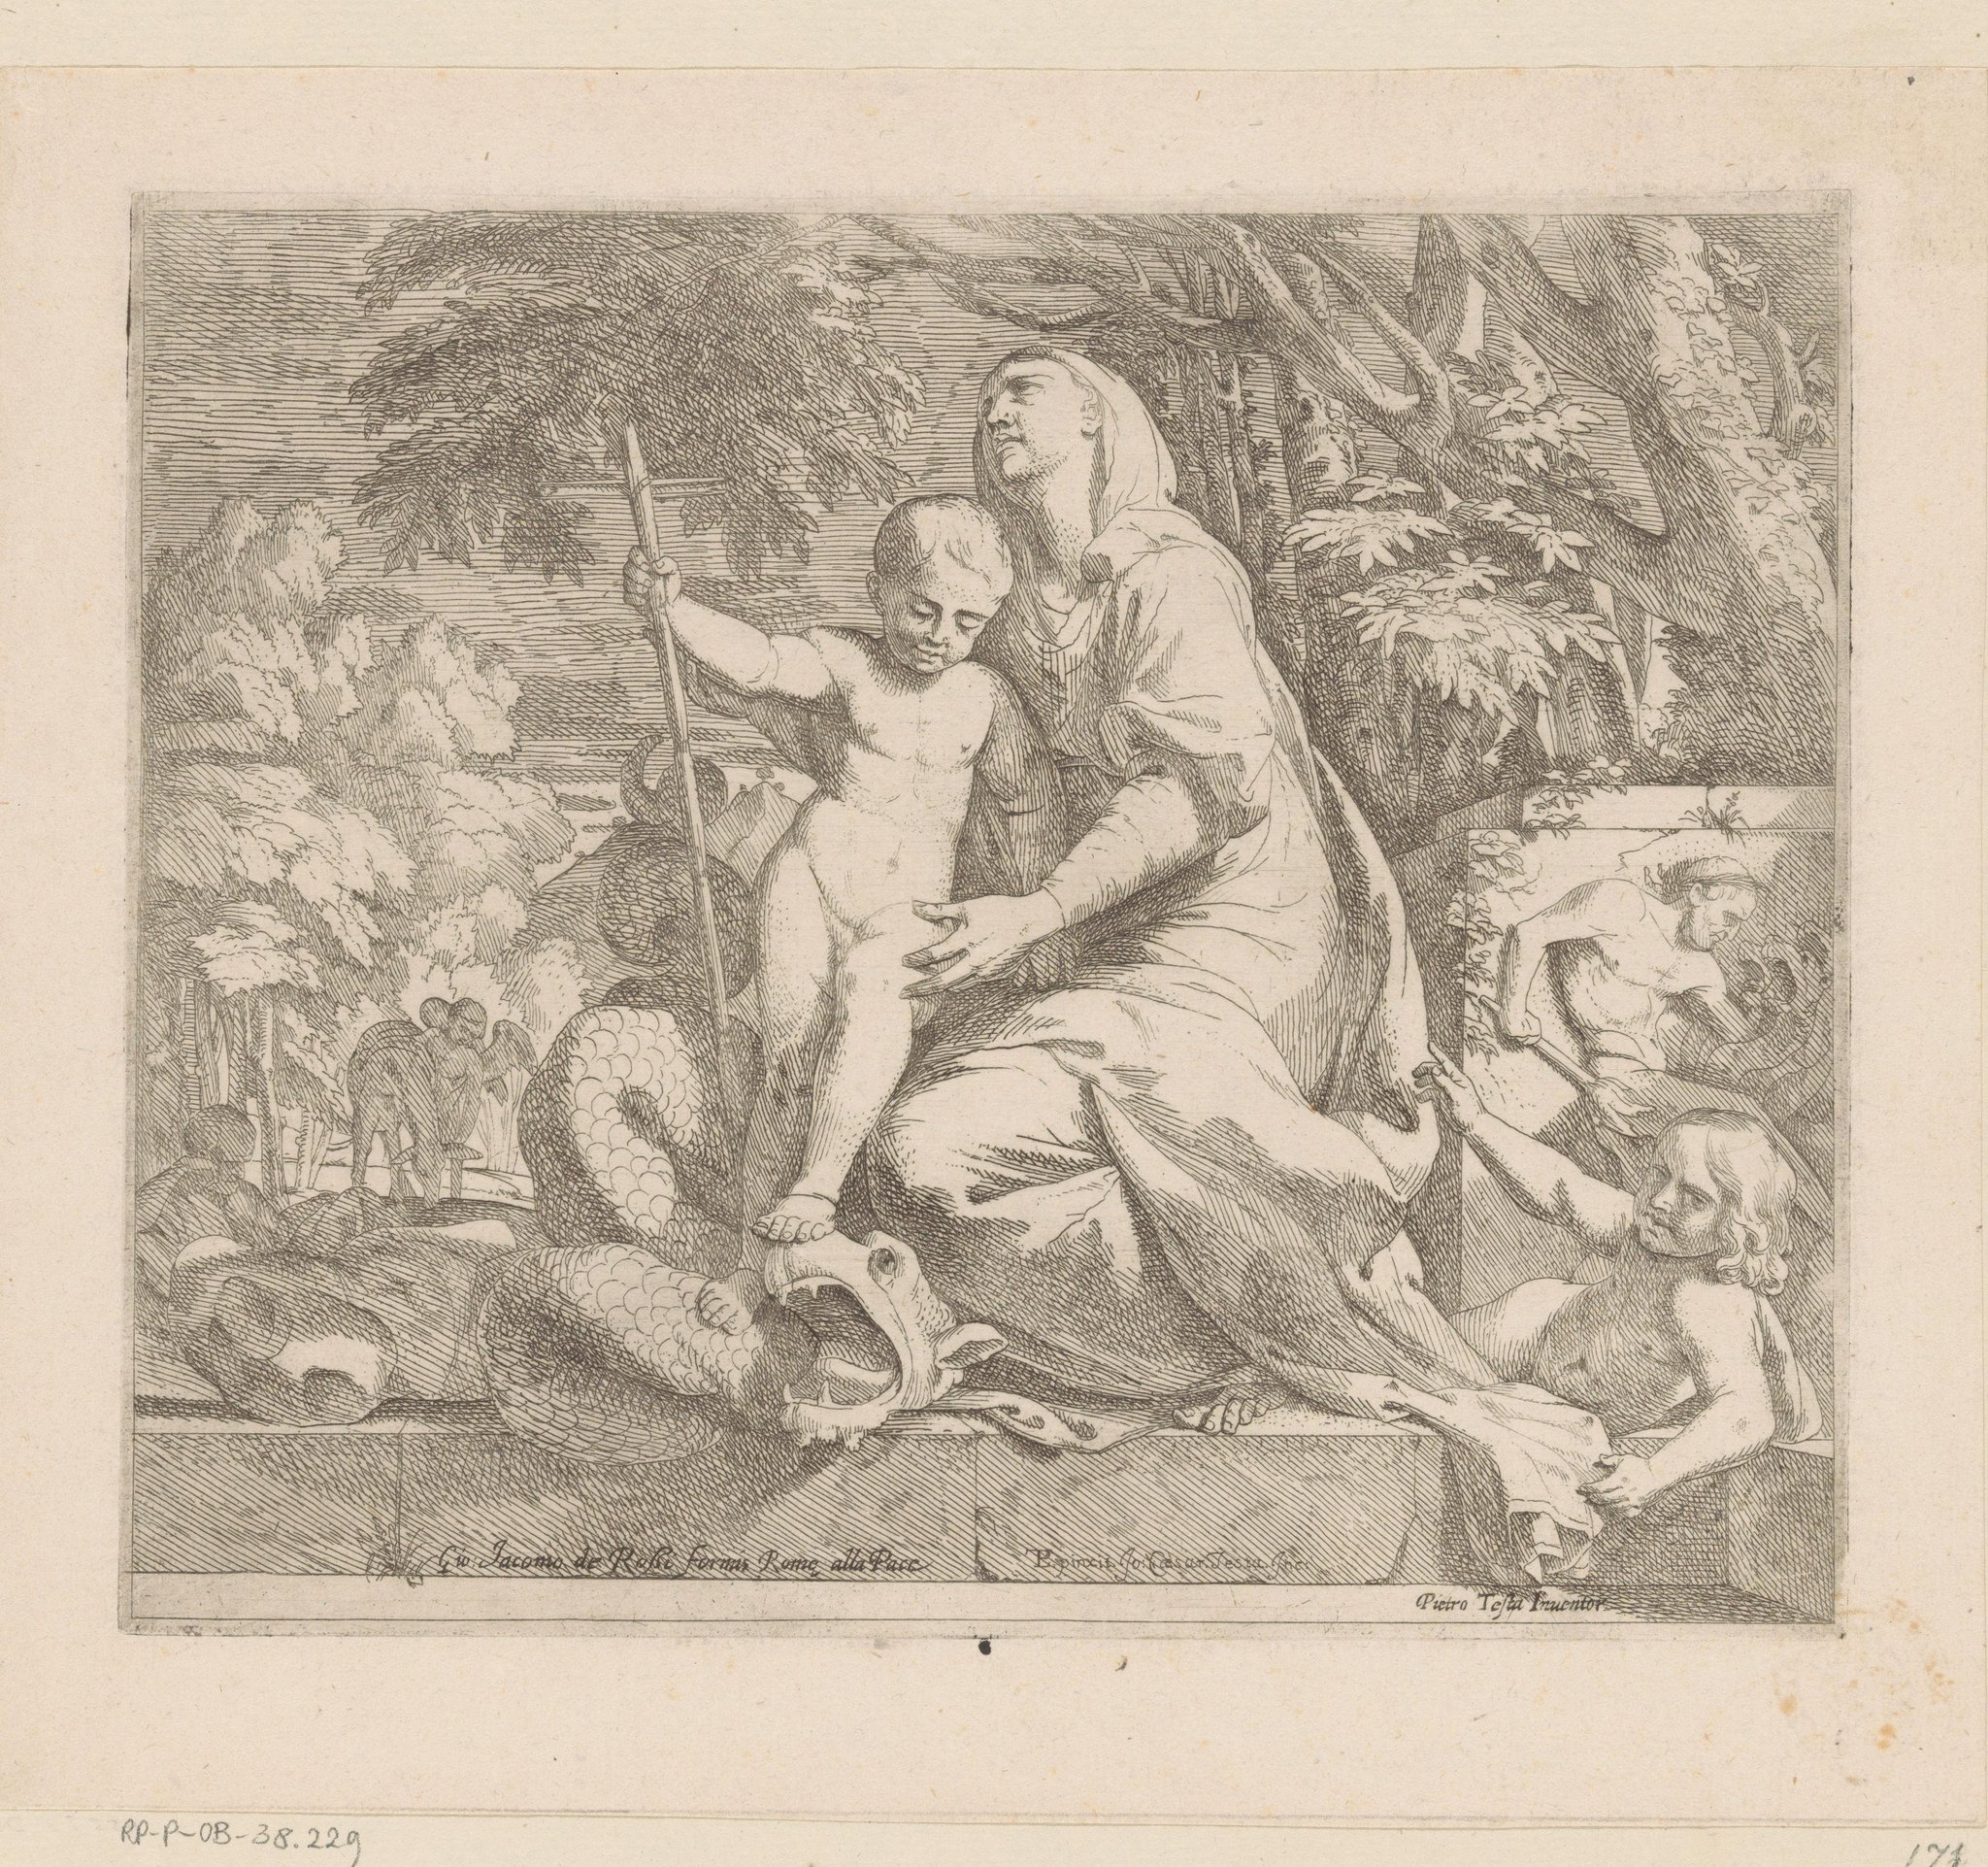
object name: print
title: Rust op de vlucht naar Egypte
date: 1637-1691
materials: paper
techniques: etching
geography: rome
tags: christ-child on mary's arm fighting the dragon, rest on the flight into egypt, piece of sculpture, reproduction of a piece of sculpture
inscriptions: collector's mark: Lugt 240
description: Maria zit in een landschap en kijkt naar boven. Het Christuskind, met kruisstaf, steunt tegen haar schoot en staat op een draak. Op de voorgrond rechts de jonge Johannes de Doper wijzend naar de staf van Christus. Achter hem een gebeeldhouwd reliëf met Hercules die de Hydra van Lerna doodt. Op de achtergrond links een gevallen sculptuur, de rustende Jozef en een putto bij de ezel.